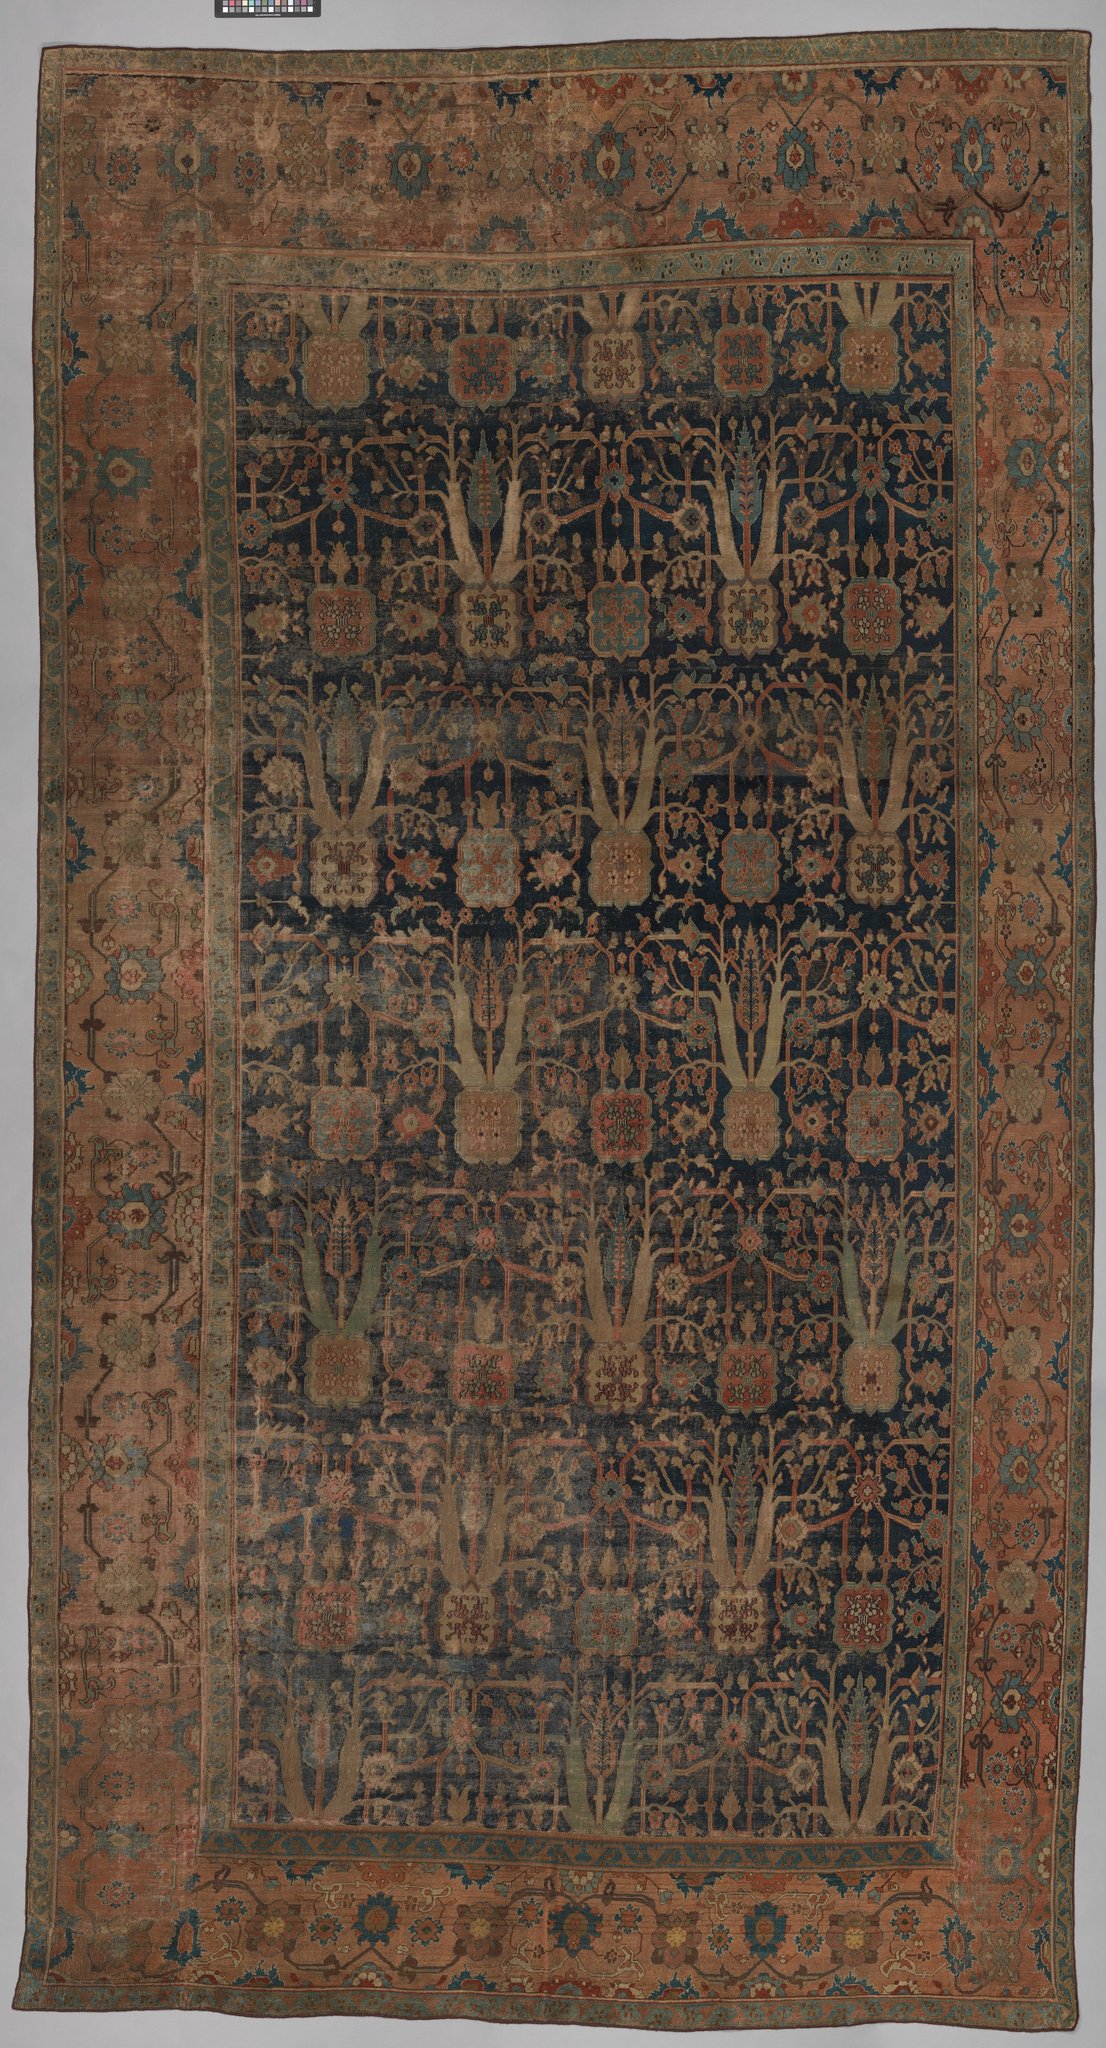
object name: carpet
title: Carpet with Repeating Tree Design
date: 1667-1733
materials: cotton, wool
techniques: asymmetrically knotted pile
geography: iran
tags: flowers,trees